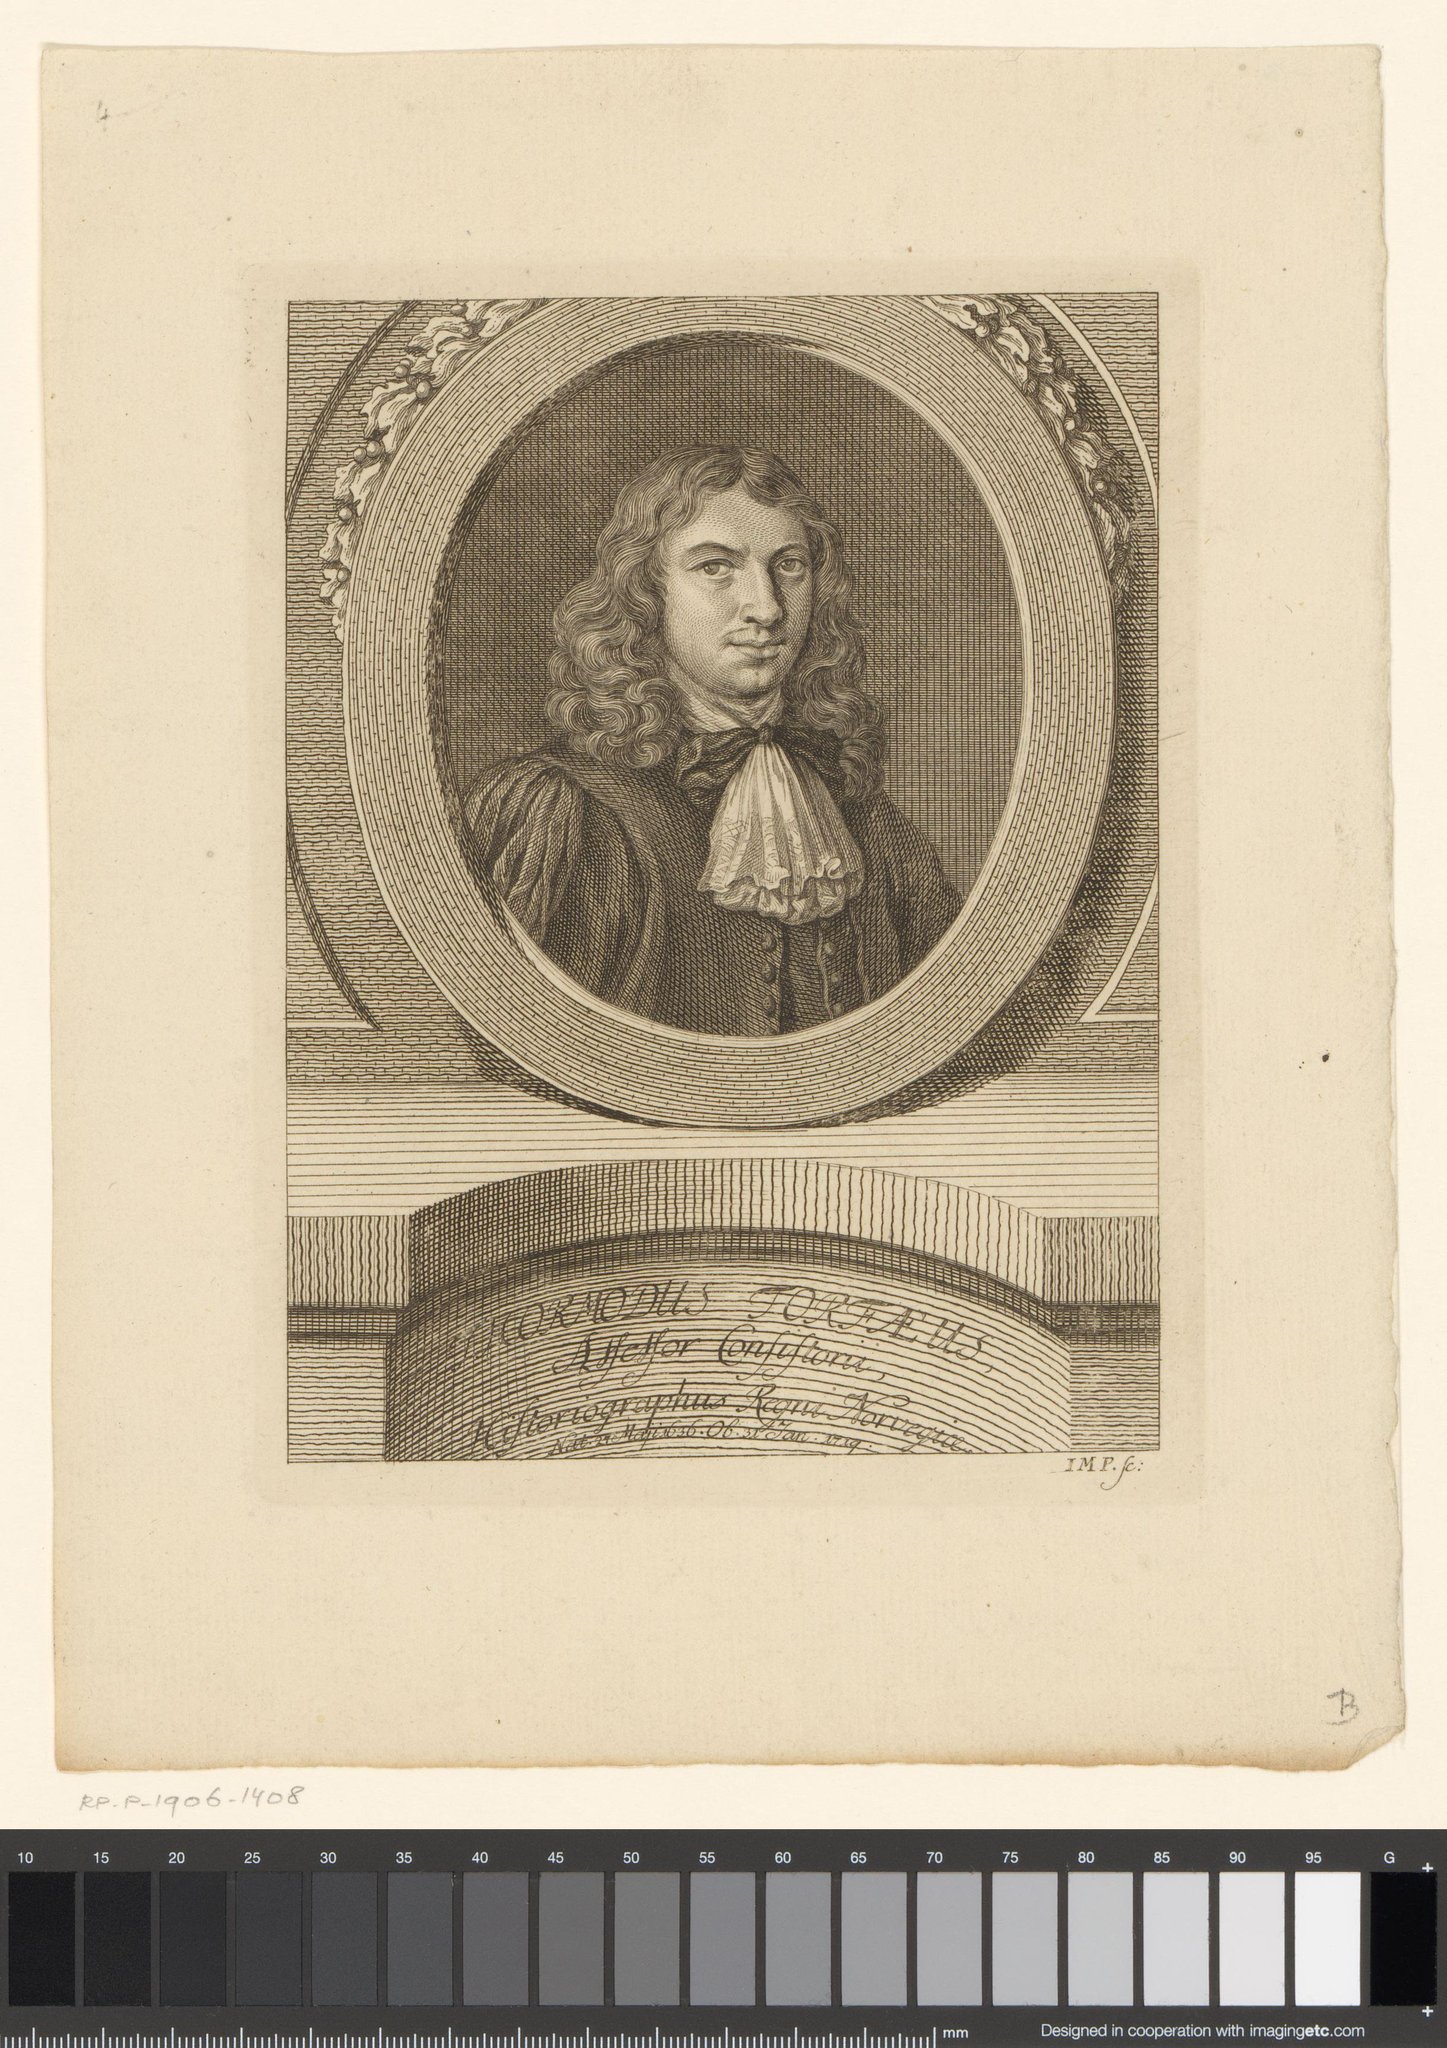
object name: print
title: Portret van Thormodus Torfaeus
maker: johann martin preissler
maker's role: print maker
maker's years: 1715-1794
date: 1725-1794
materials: paper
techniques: engraving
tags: historical persons, portrait of a writer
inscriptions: collector's mark: Lugt 2228